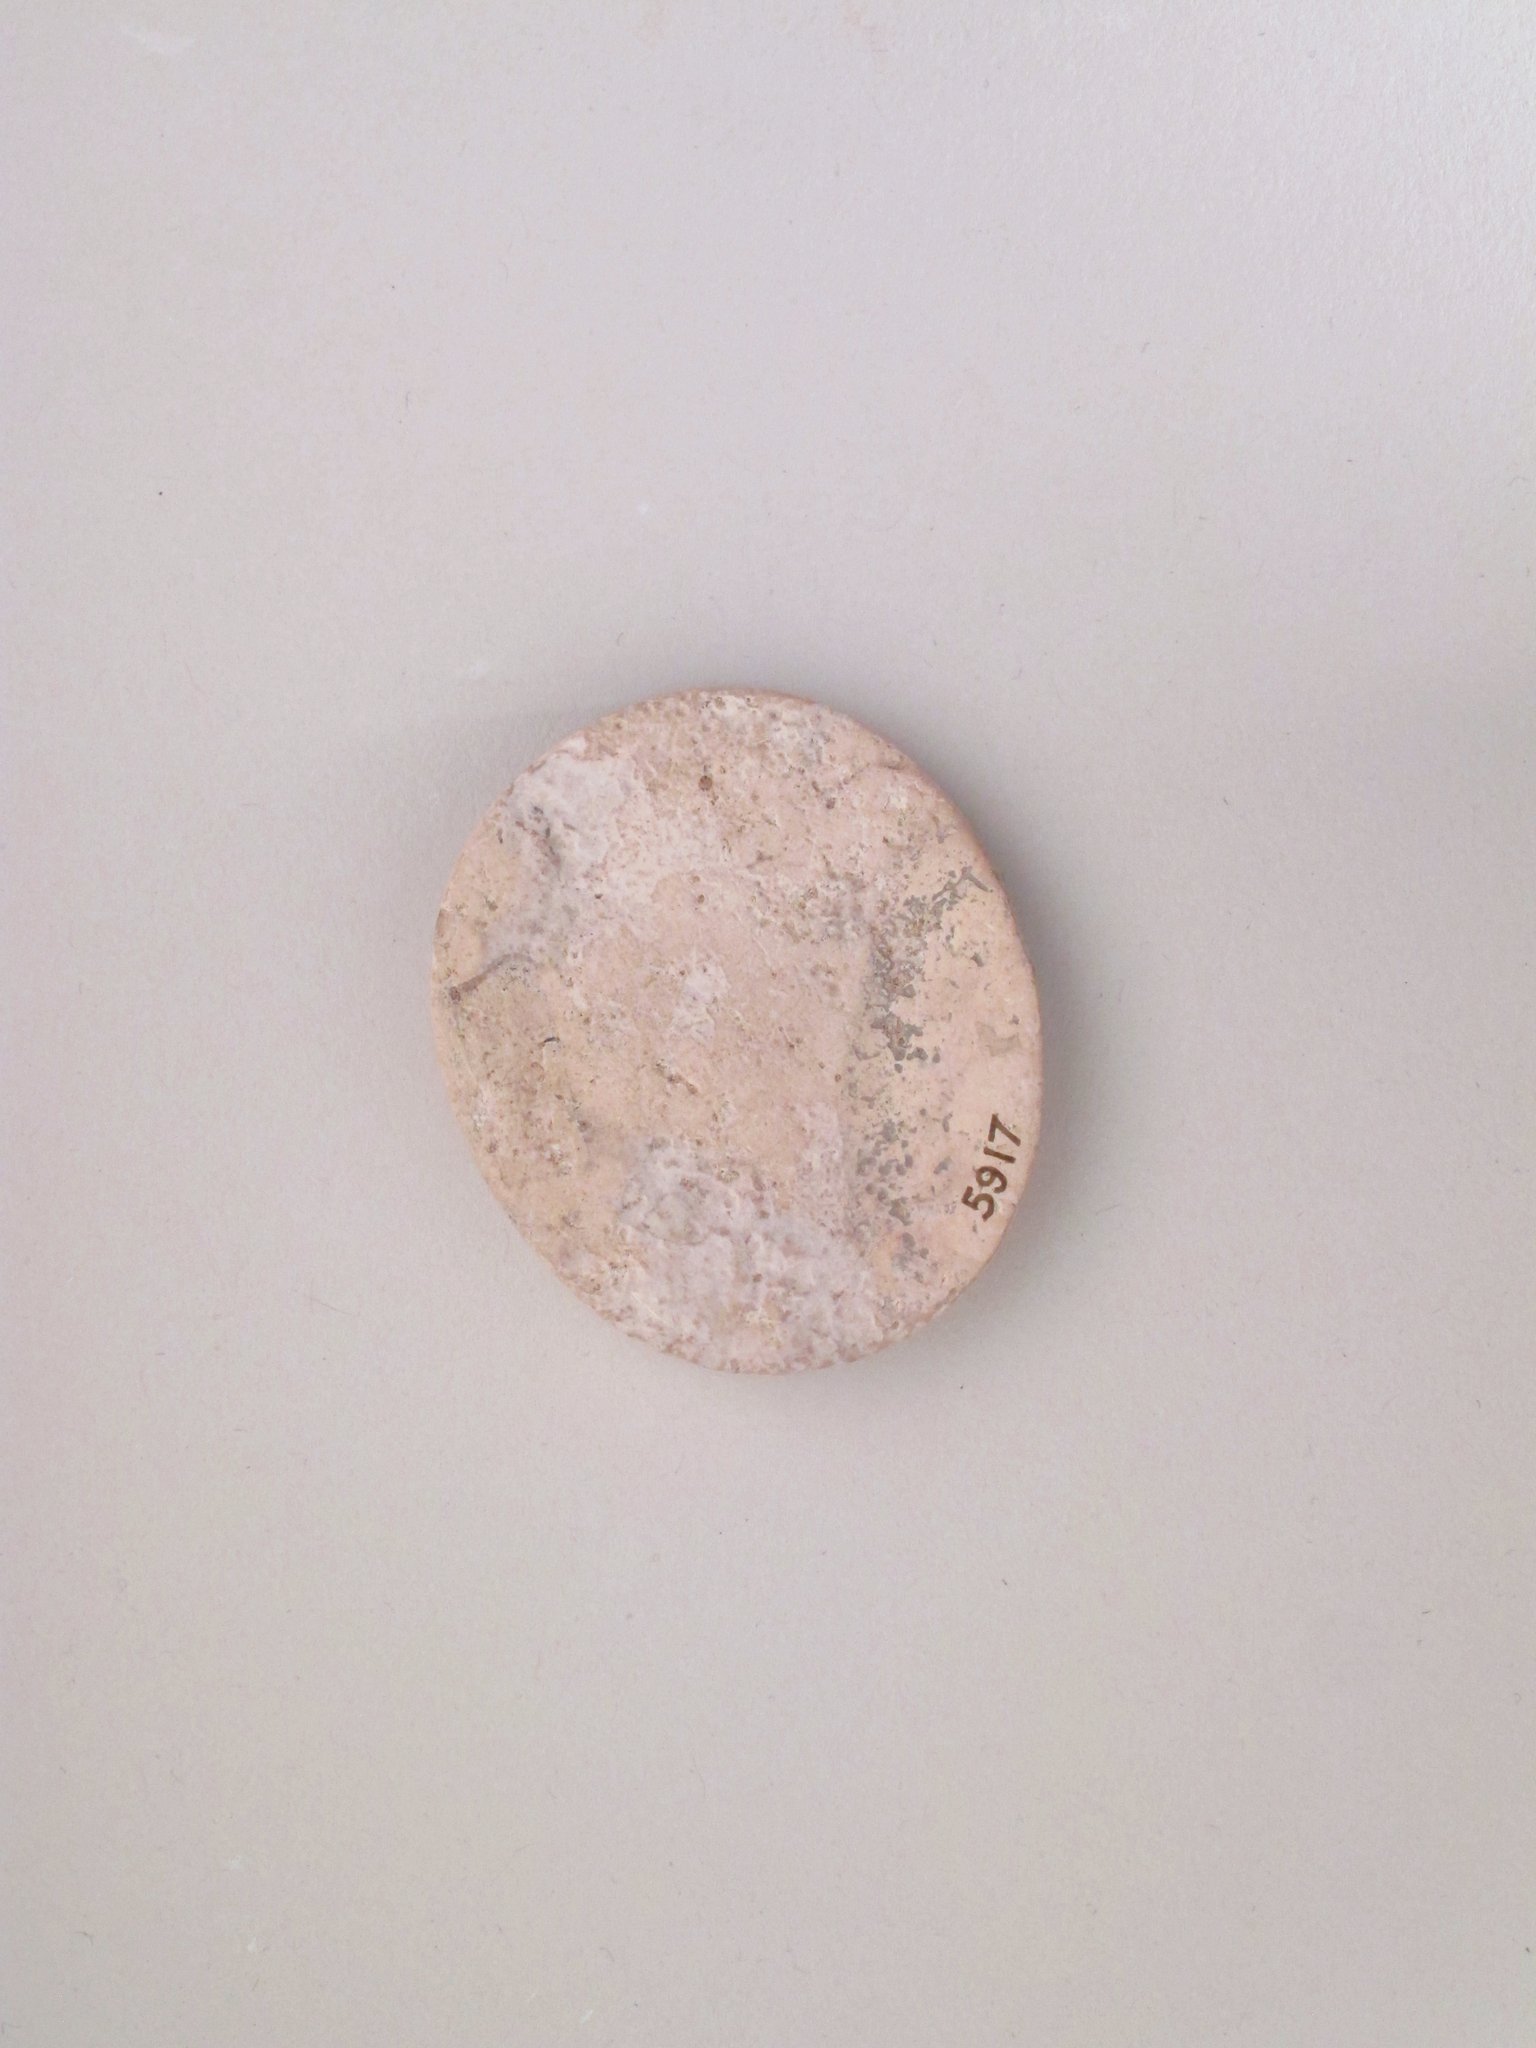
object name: roundel, disk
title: Ivory disk of a pyxis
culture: cypriot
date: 1300-1101 BCE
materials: ivory